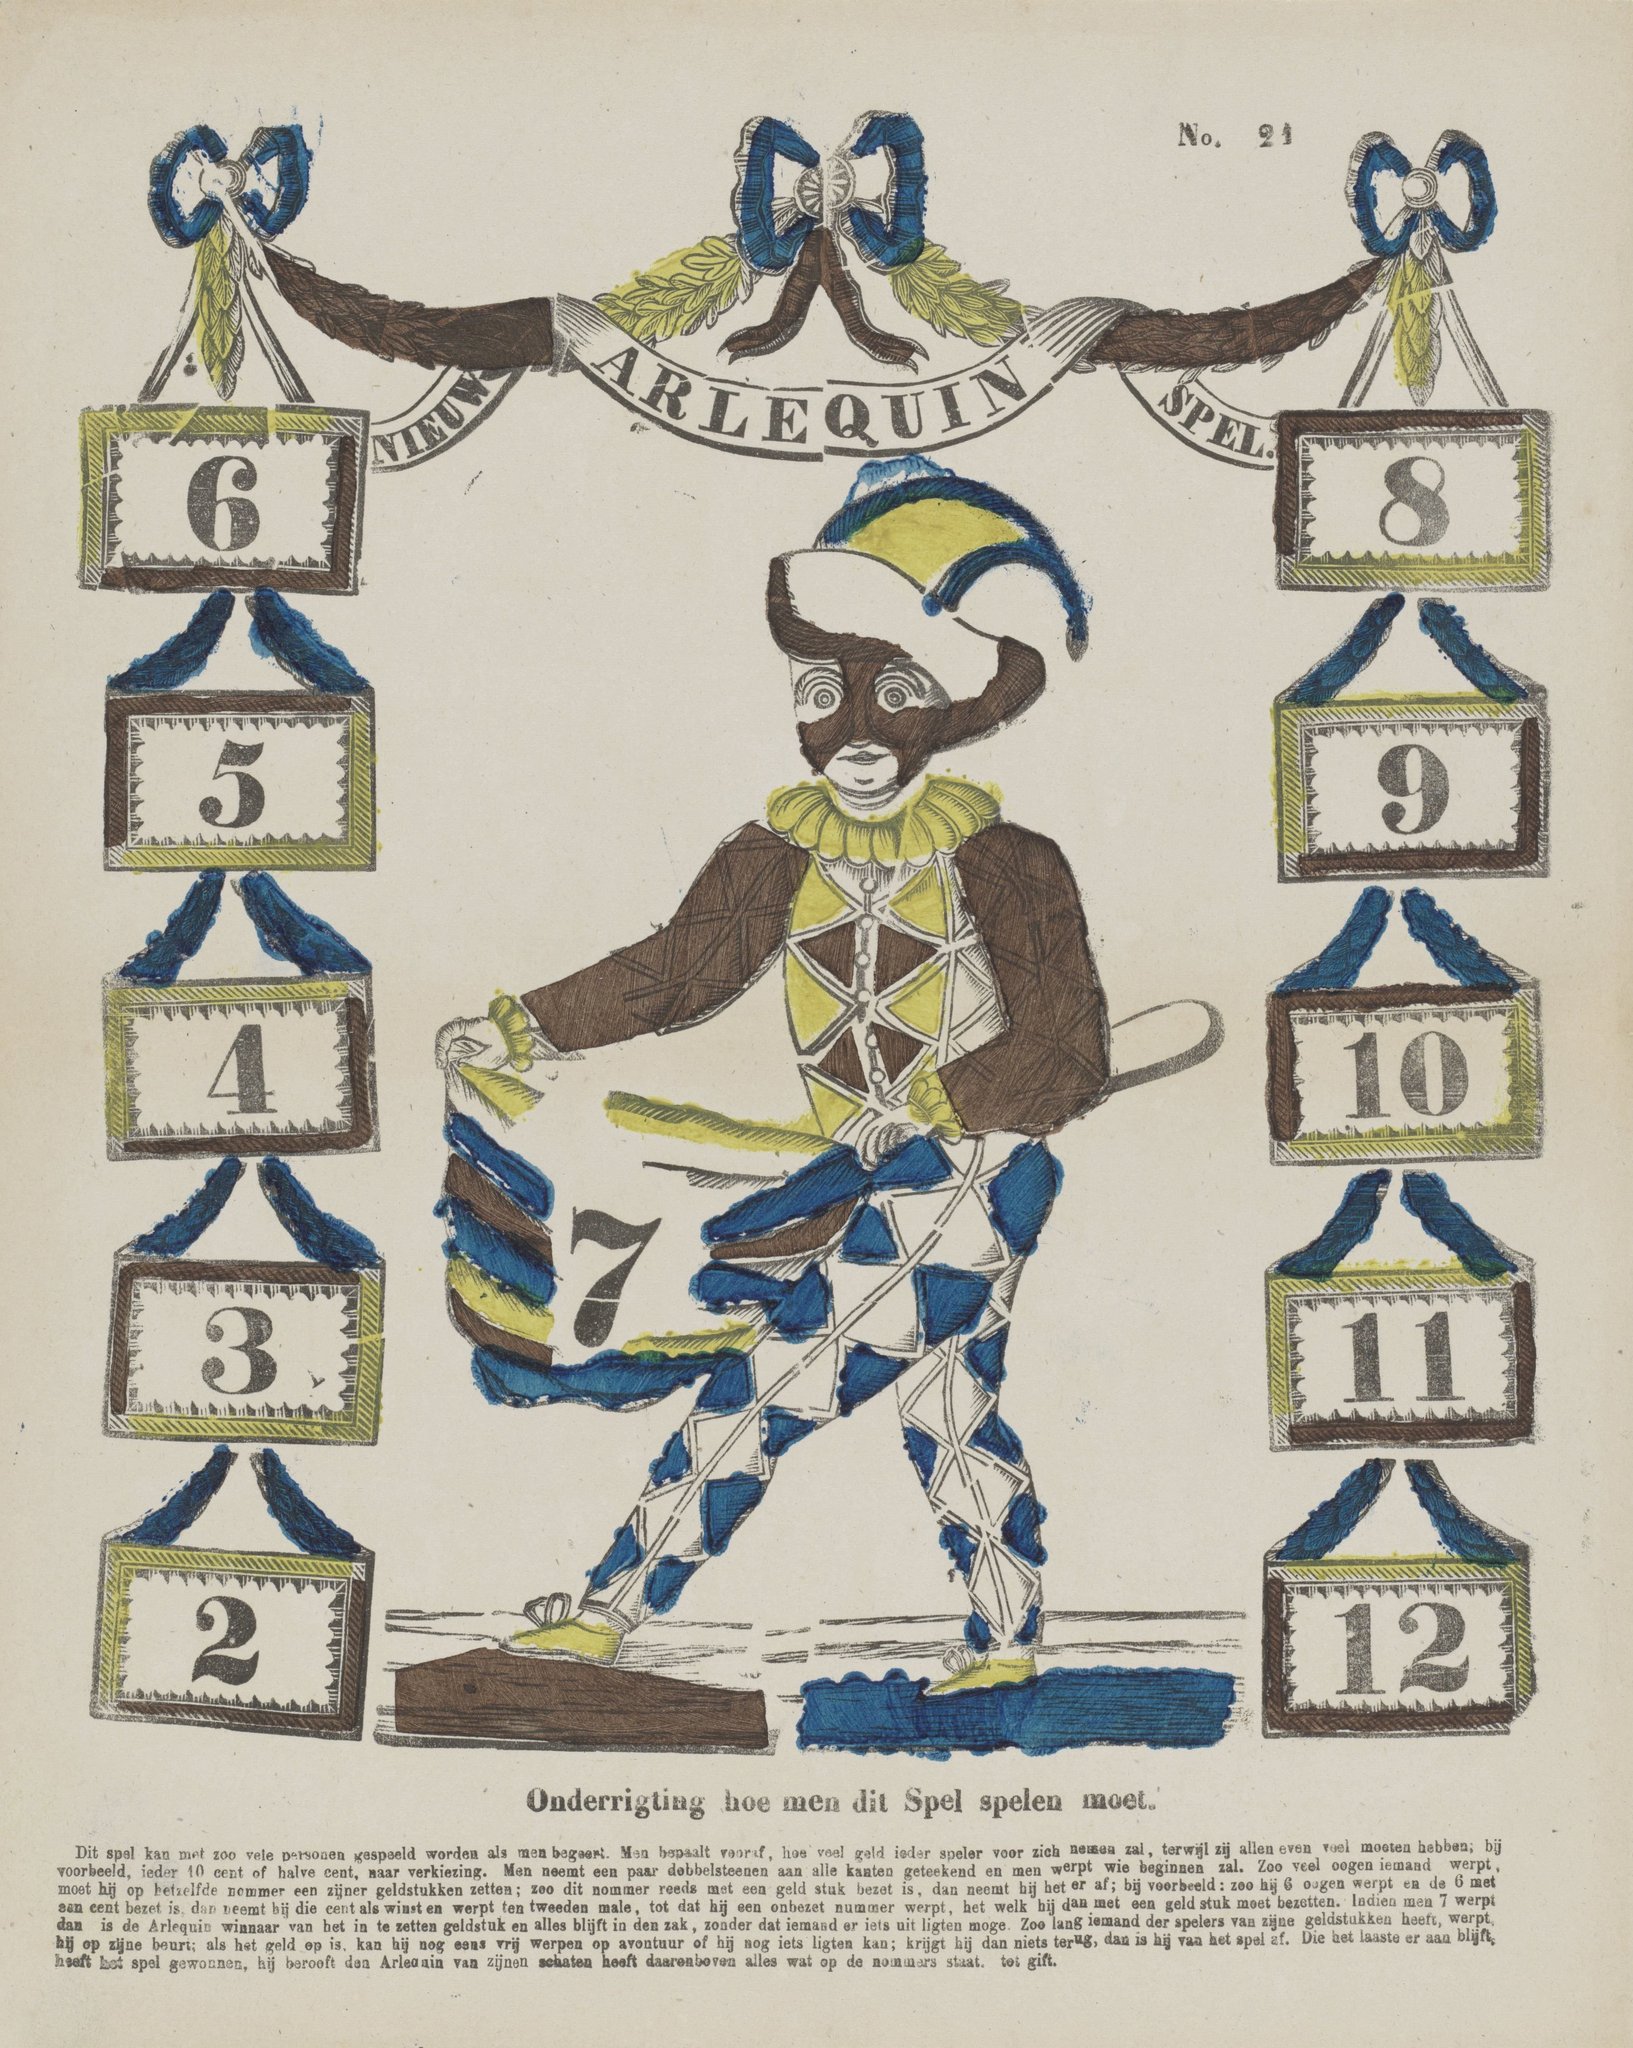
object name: popular print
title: Nieuw Arlequin spel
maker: Anonymous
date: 1848-1881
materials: paper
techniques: colour, letterpress printing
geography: netherlands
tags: board-games of chance, types in 'commedia dell'arte': harlequin, board-games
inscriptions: collector's mark: Lugt 2760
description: Bordspel met in het midden van het speelveld een harlekijn die in zijn geopende handen een zak houdt met daarop het cijfer 7. Rondom hem een guirlande waaraan medaillons hangen met de cijfers 2 tot en met 12. In de ondermarge de spelregels in boekdruk. Genummerd rechtsboven: No. 21.